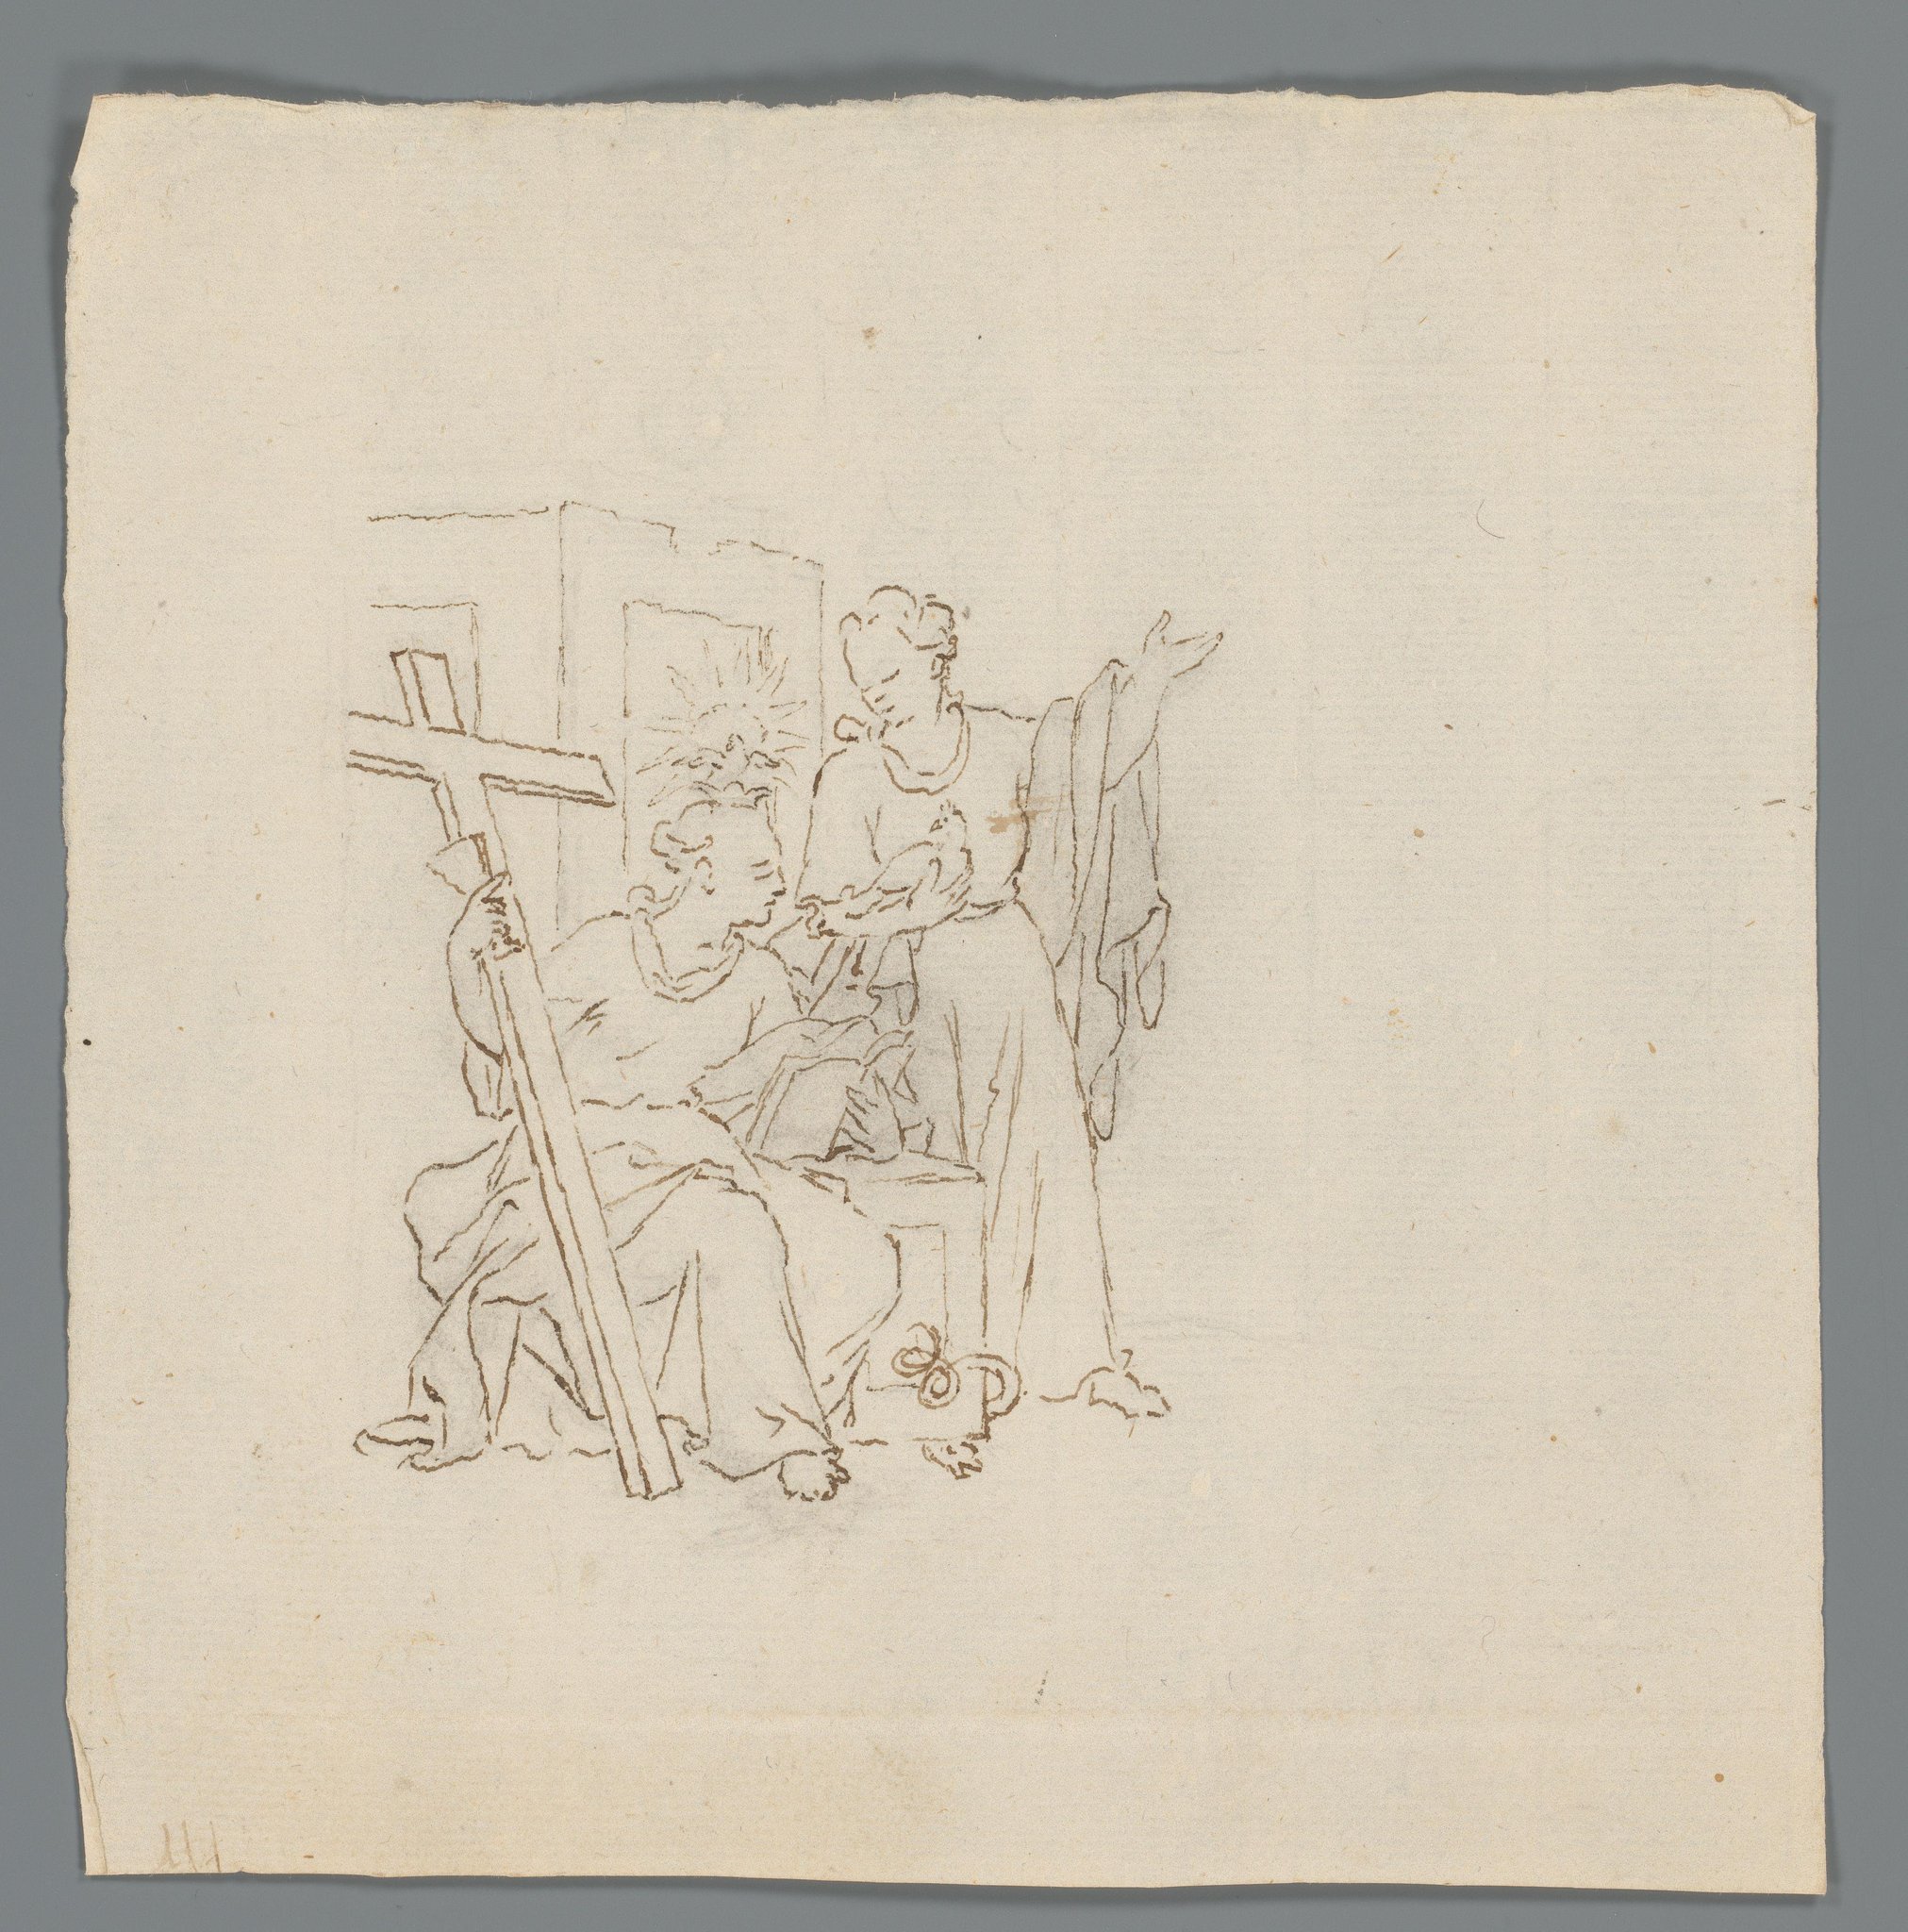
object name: drawing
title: Geloof en Hoop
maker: matthijs balen (1684-1766)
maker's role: draughtsman, painter, print maker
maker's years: 1684-1766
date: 1694-1766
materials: paper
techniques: pen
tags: faith, 'fides'; 'fede', 'fede catholica', 'fede christiana', 'fede christiana catholica' (ripa) ~ one of the three theological virtues, hope, 'spes'; 'speranza divina e certa' (ripa) ~ one of the three theological virtues